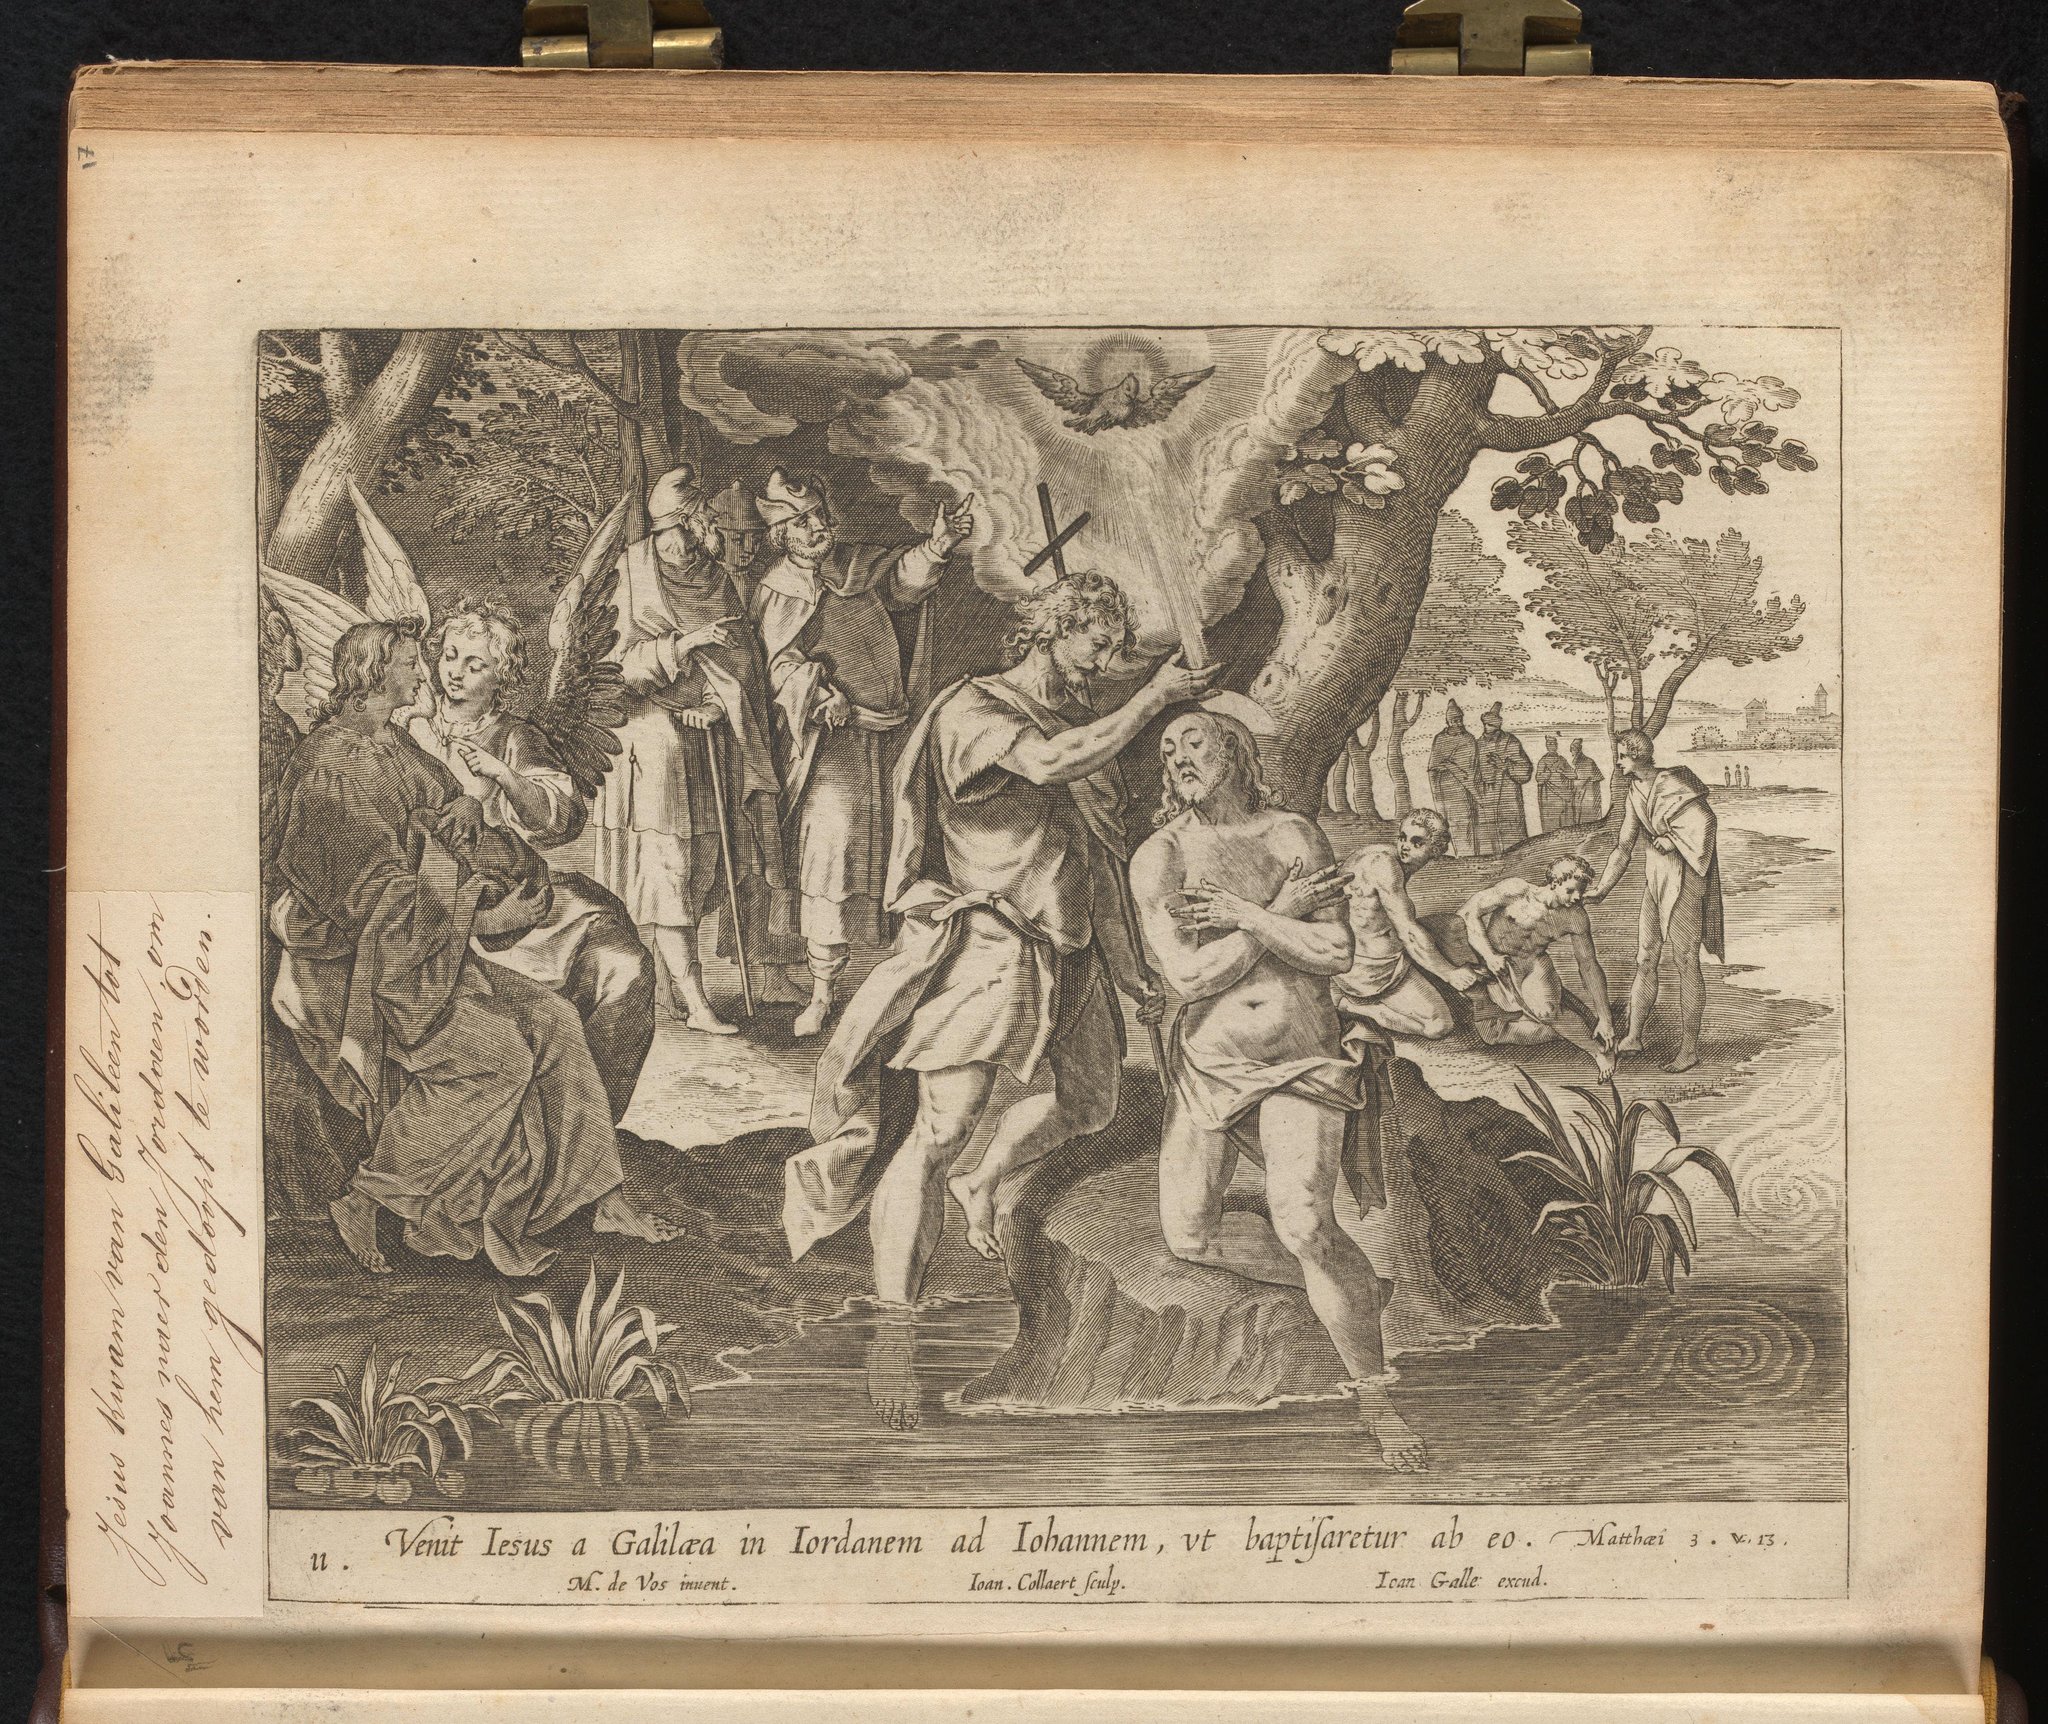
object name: print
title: Vita, passio et Resvrrectio Iesv Christi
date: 1598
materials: paper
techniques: engraving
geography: antwerp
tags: baptism of christ in the river jordan: john the baptist pouring out water on christ's head: the holy ghost descends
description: Prent in: s.n. Aldernouwkeurigste verhandelinge der geschiedenissen van het Nieuw Testament (...). Antwerpen: Cornelis Marten Spanoghe, 1783, p. 20-21.